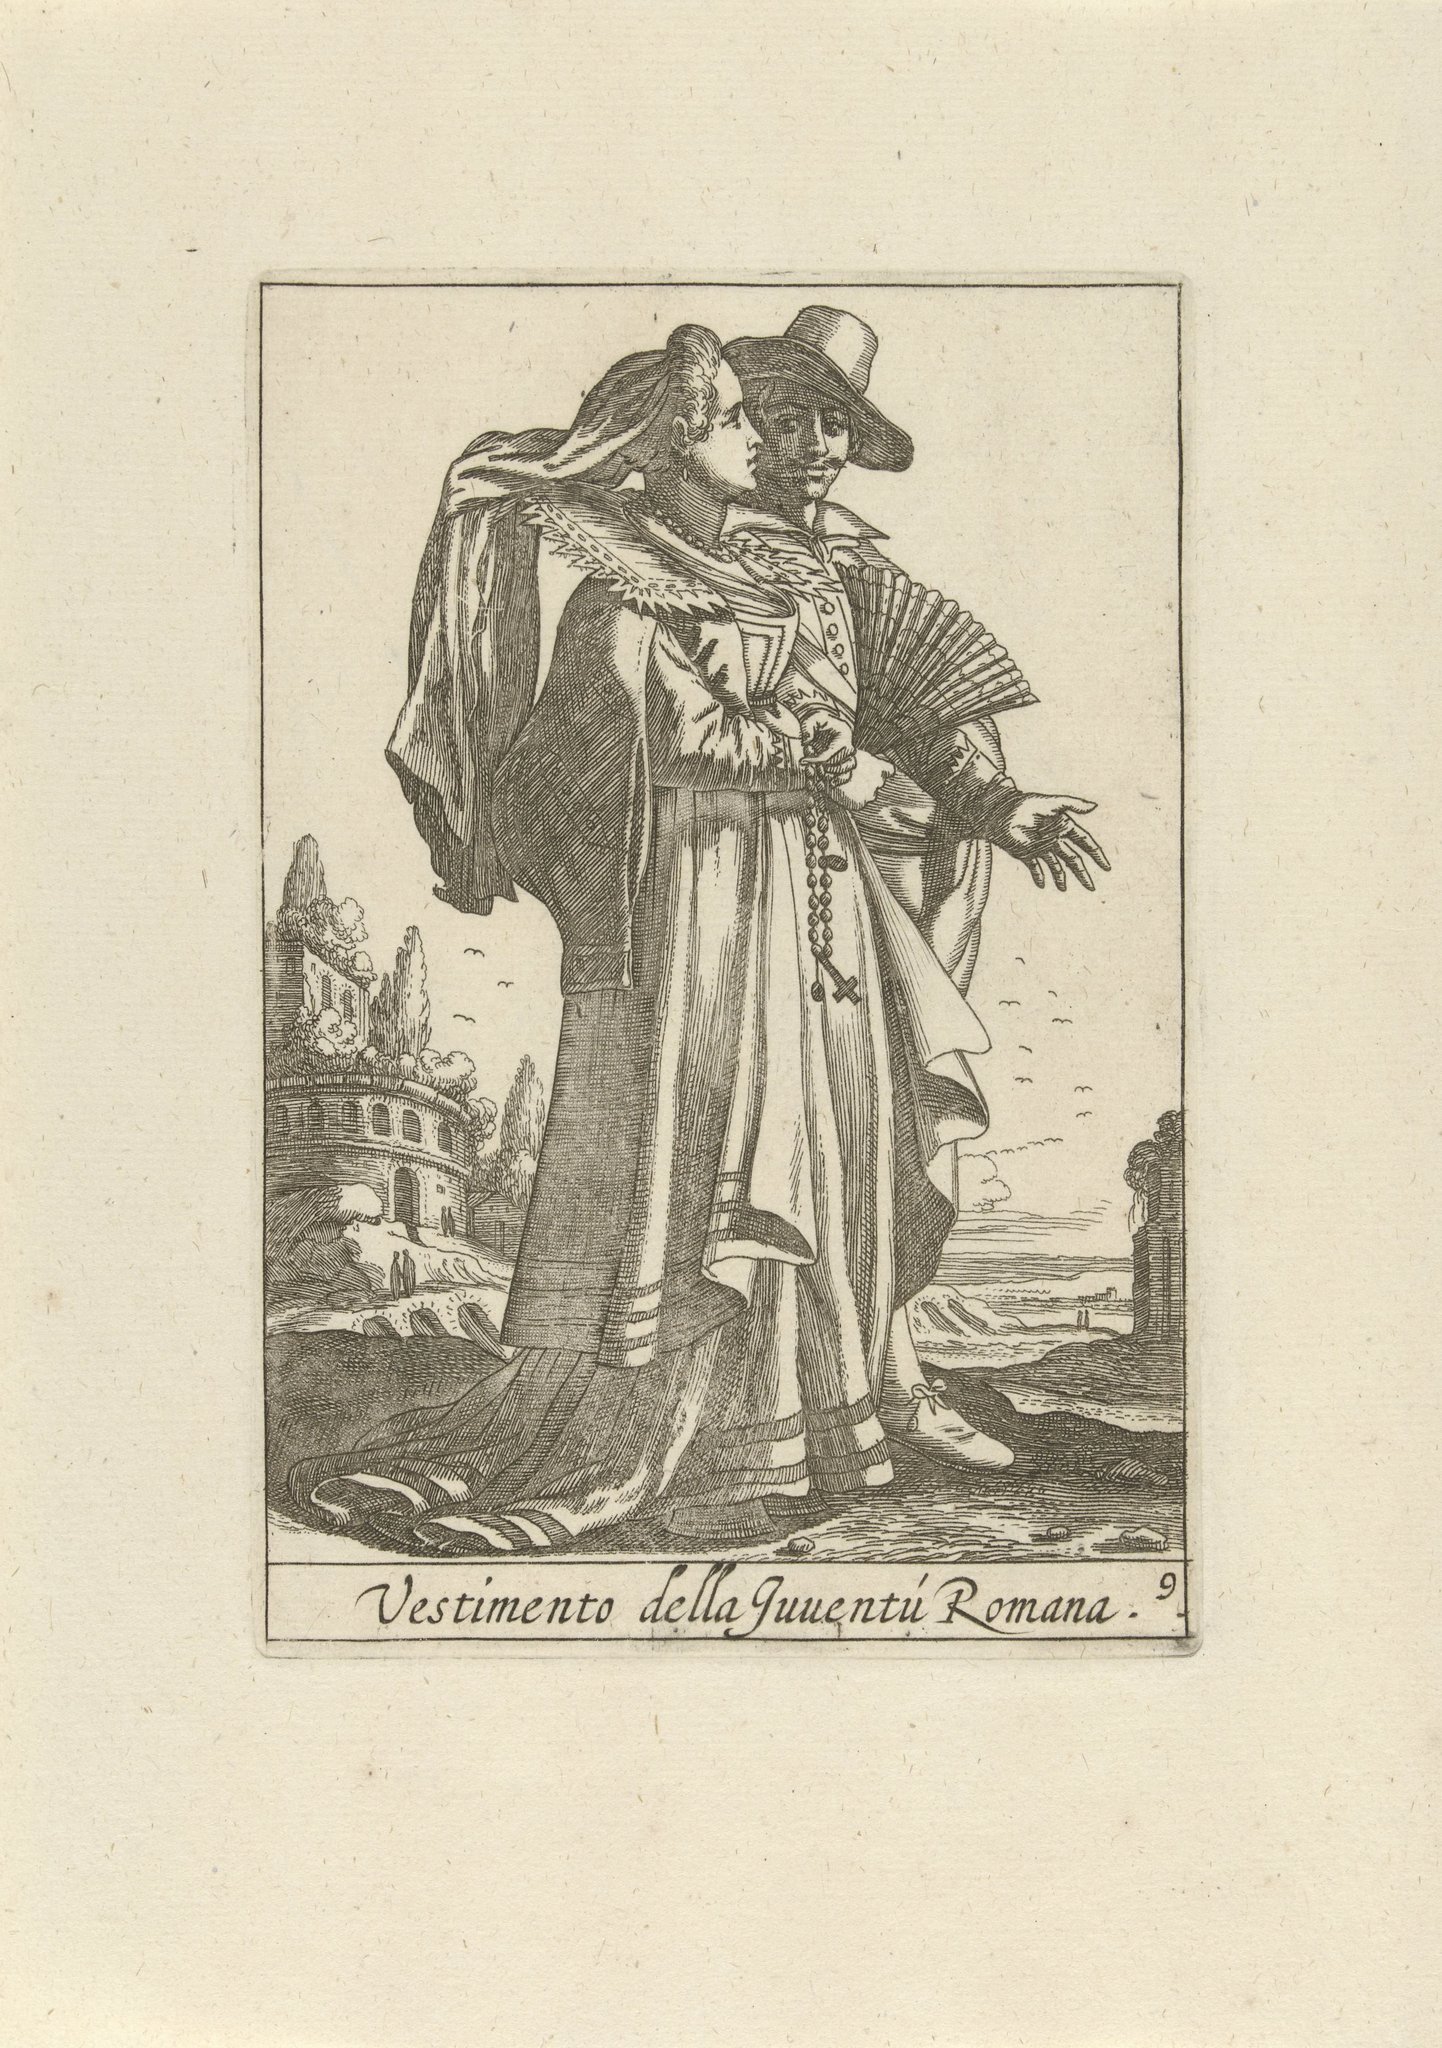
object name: print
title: Jong paar gekleed volgens de Romeinse mode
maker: Anonymous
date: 1720-1772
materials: paper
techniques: etching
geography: amsterdam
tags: europeans (with name) (+ costume)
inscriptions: collector's mark: Lugt 2228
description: Landschap met een jong paar, gekleed in mode uit Rome, Italië. Het paar is ten voeten uit weergegeven, de vrouw en profil. De man staat enigszins verdekt opgesteld achter de vrouw waardoor alleen het met hoed getooide hoofd zichtbaar is. De vrouw is gehuld in een lange japon met open mouwen, in haar handen houdt ze een waaier en een rozenkrans vast. De prent maakt deel uit van een twaalfdelige serie prenten met Italiaanse kostuums.